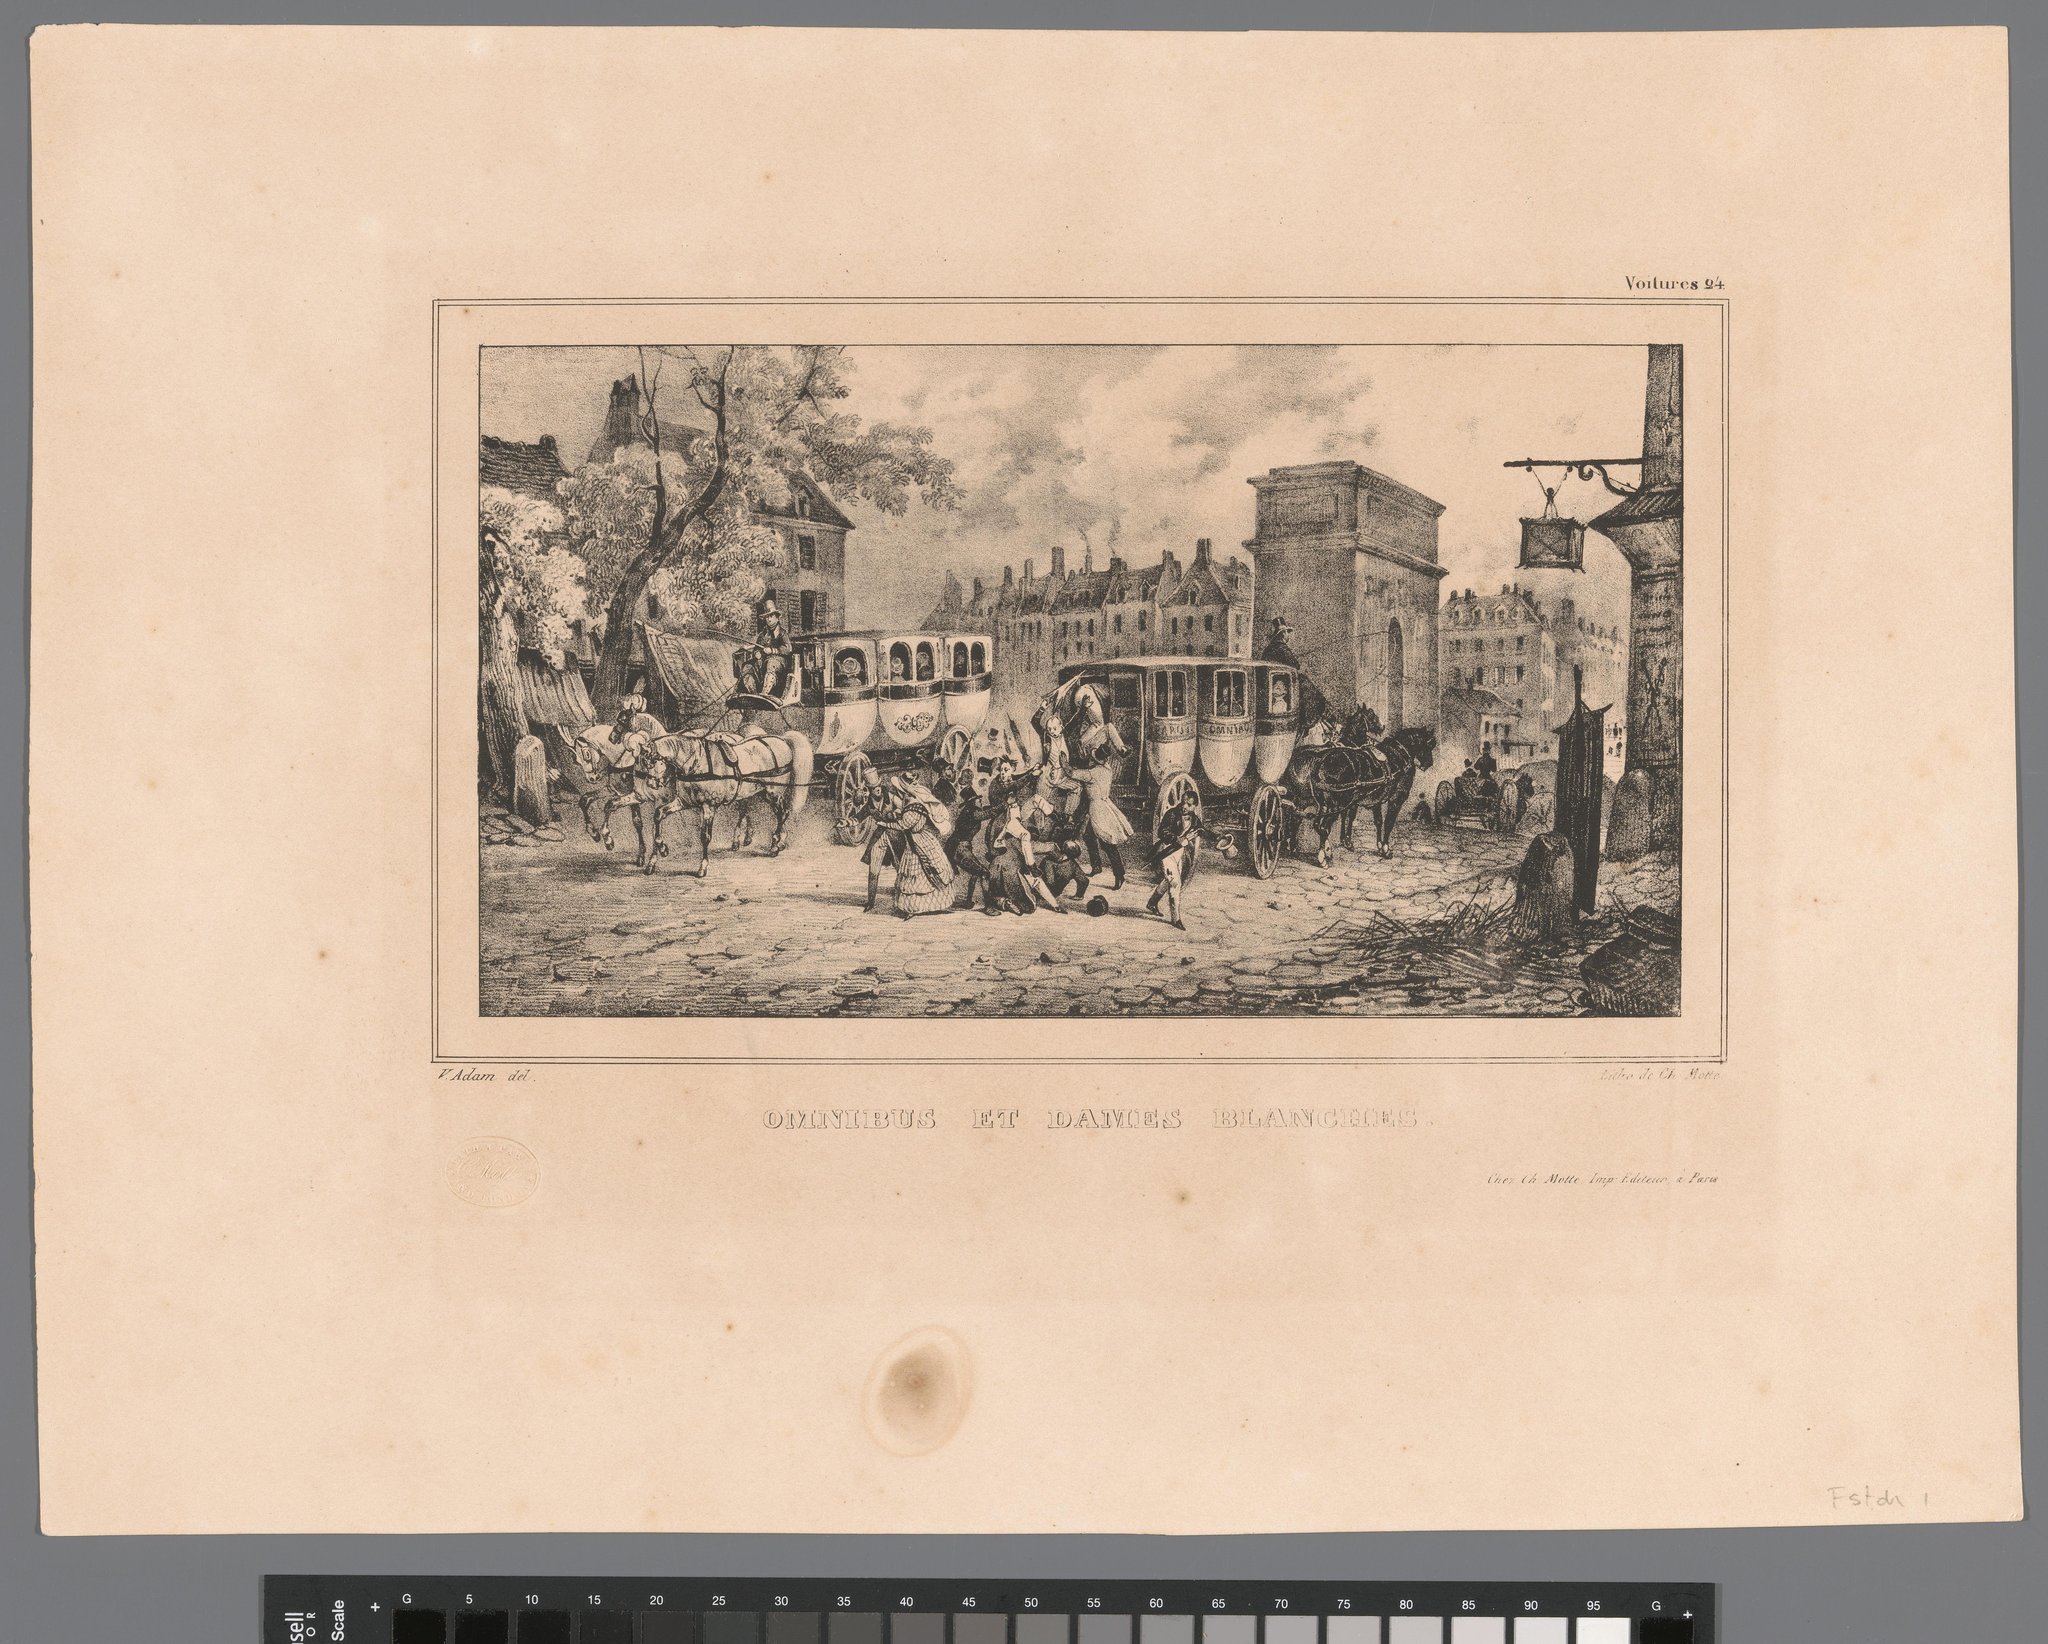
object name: print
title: Voitures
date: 1828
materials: paper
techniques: lithograph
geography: paris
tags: diligence, omnibus, horse-tram, four-wheeled vehicle drawn by two animals, passenger carriage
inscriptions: collector's mark: Lugt 2228, stamp: Lugt 1828b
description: De prentserie waar deze prent deel van uitmaakt werd in drie delen van twaalf prenten vanaf 1827 tot en met 1830 gepubliceerd. Elk van de drie delen werd voorzien van een aparte omslag. In 1828 reden in Parijs de eerste omnibussen (van de 'Entreprise générale des omnibus', EGO). Al snel kreeg de EGO concurrentie van een andere omnibus-maatschappij: de 'Dames Blanches'. De 'Dame Blanche'-omnibussen waren wit en reden aanvankelijk met witte paarden.